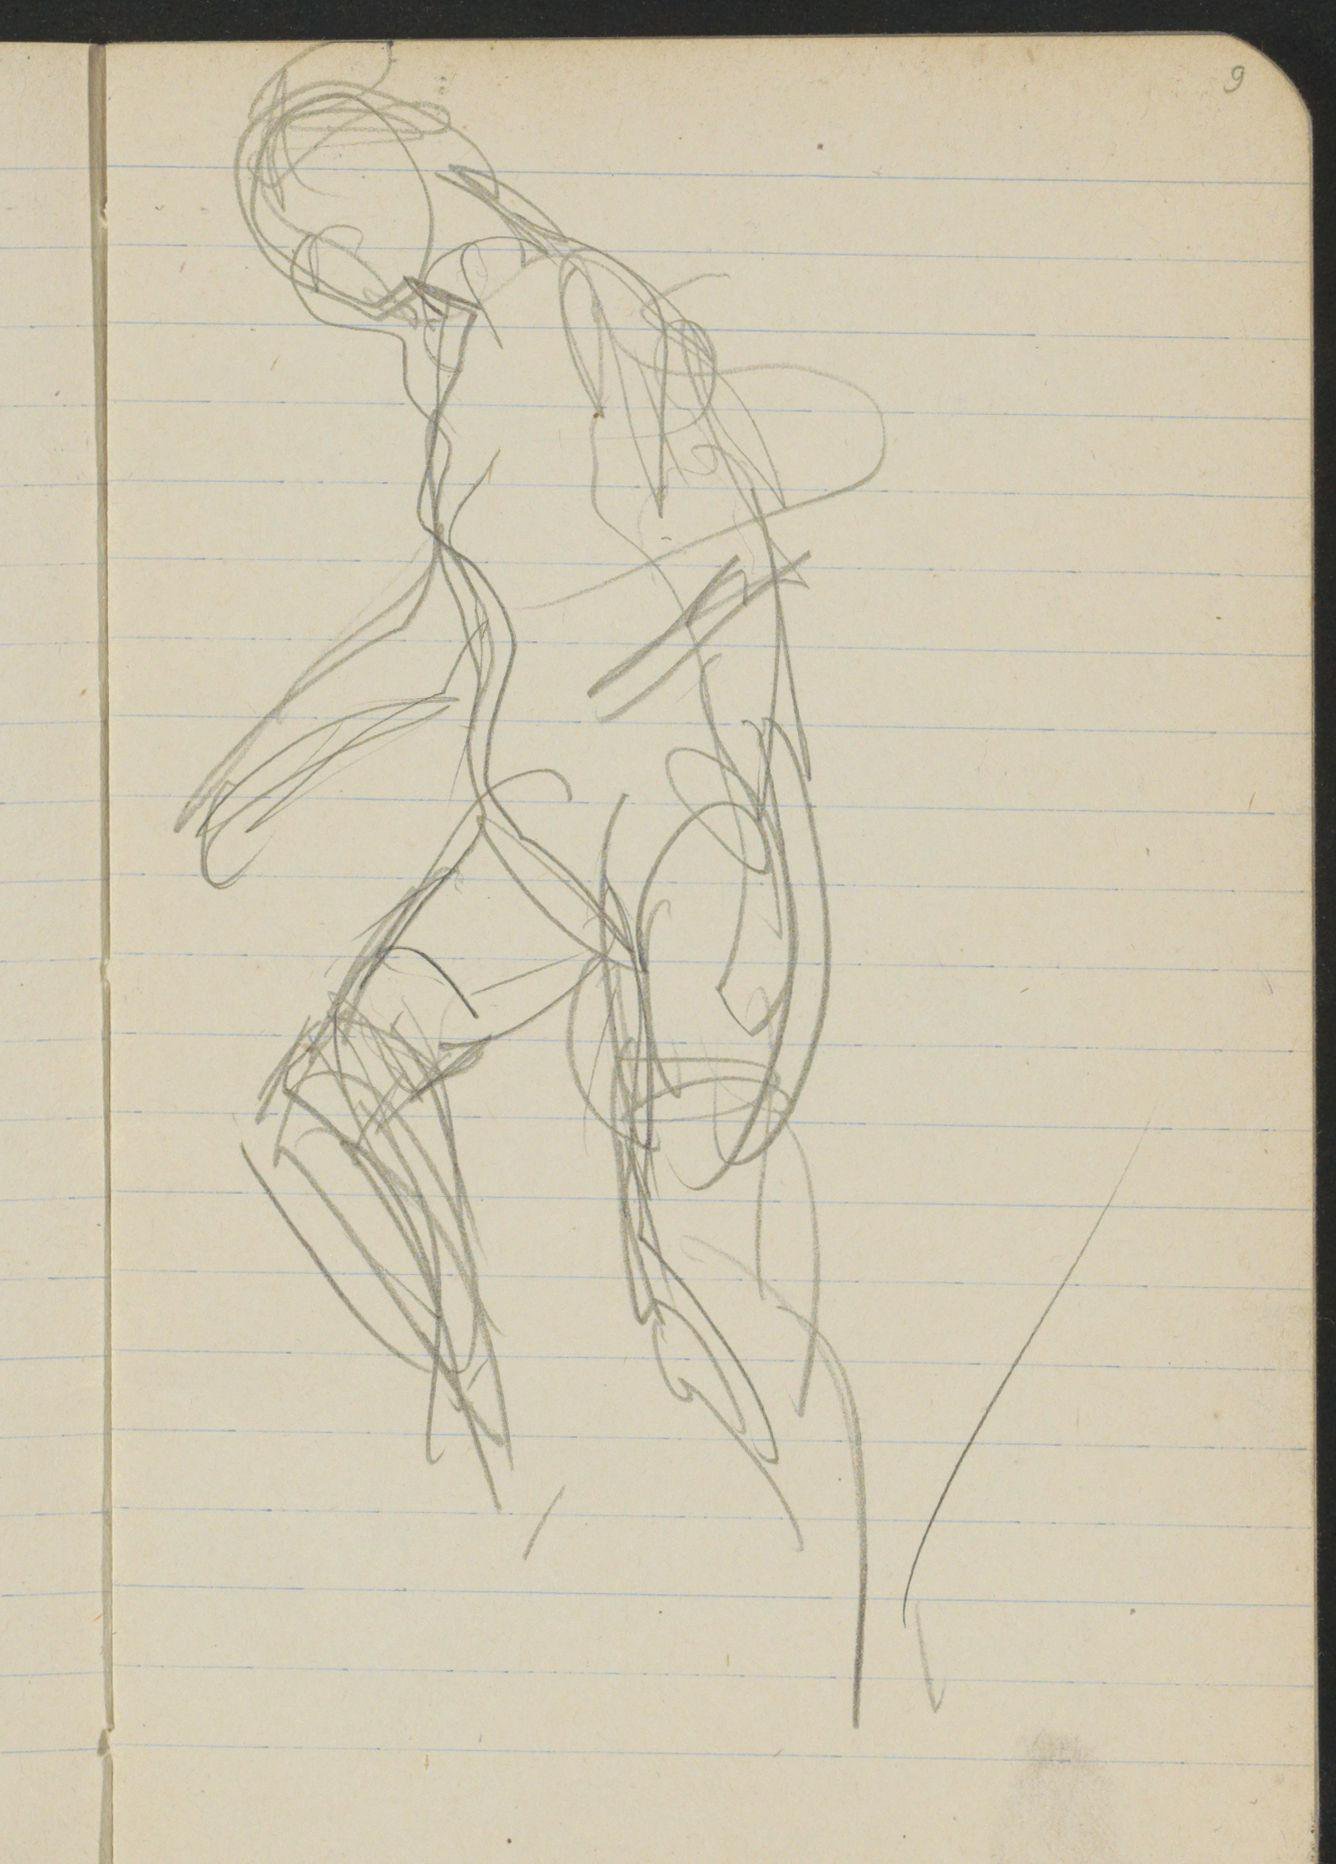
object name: sketchbook leaf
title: Lopende vrouw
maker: isaac israels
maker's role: draughtsman, painter, print maker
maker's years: 1865-1934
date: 1875-1934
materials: pencil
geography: the hague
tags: walking - aa - female human figure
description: Pagina 9 uit schetsboek XL met 40 pagina's.